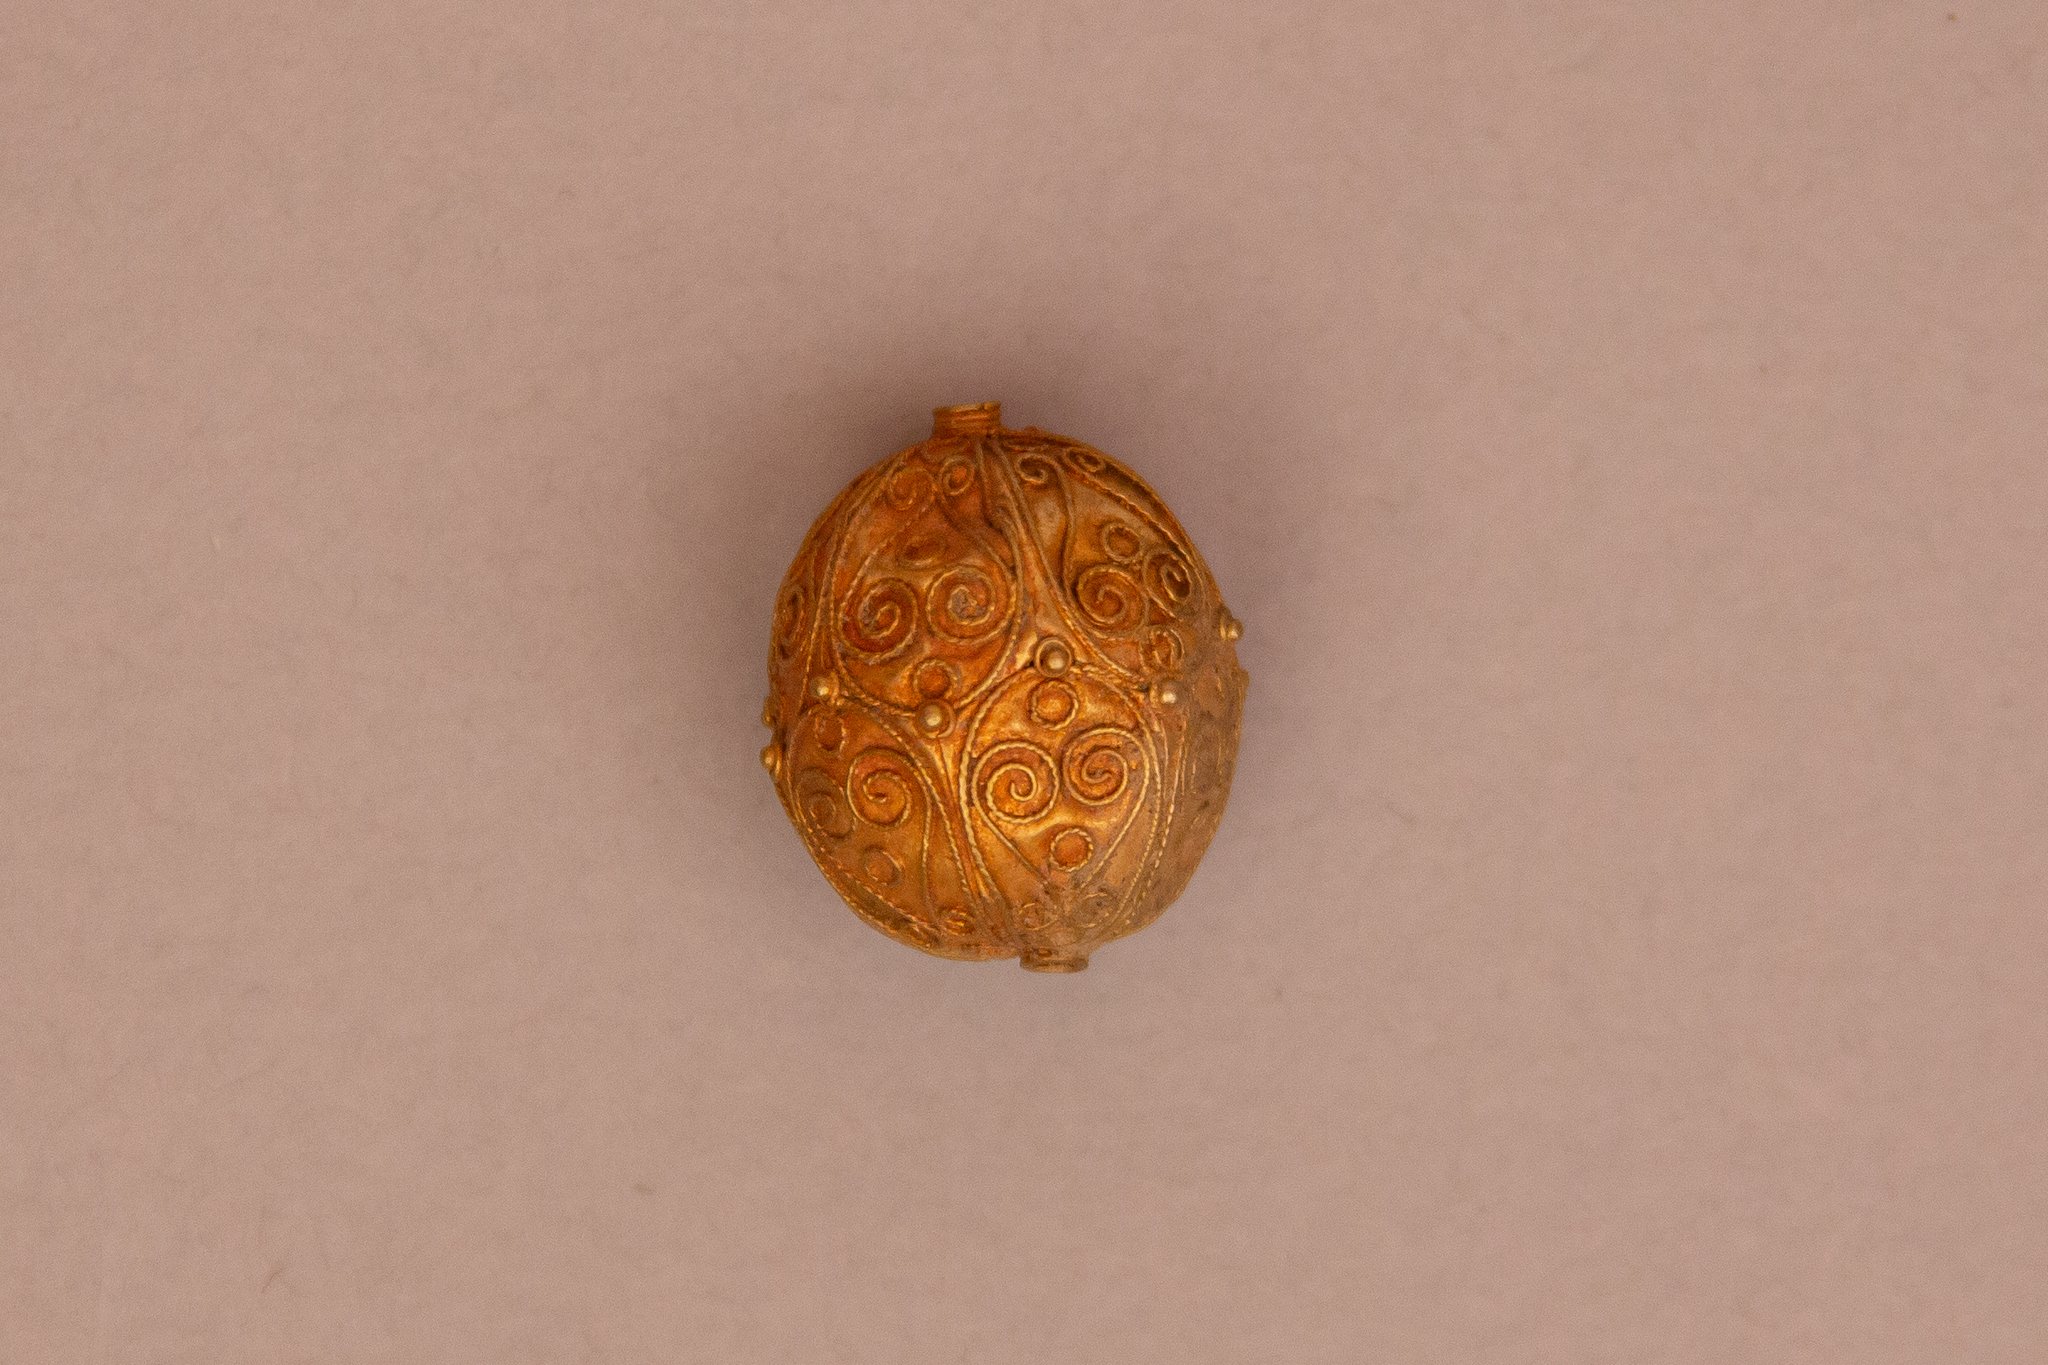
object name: bead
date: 1001-1100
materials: gold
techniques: filigree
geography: egypt or syria